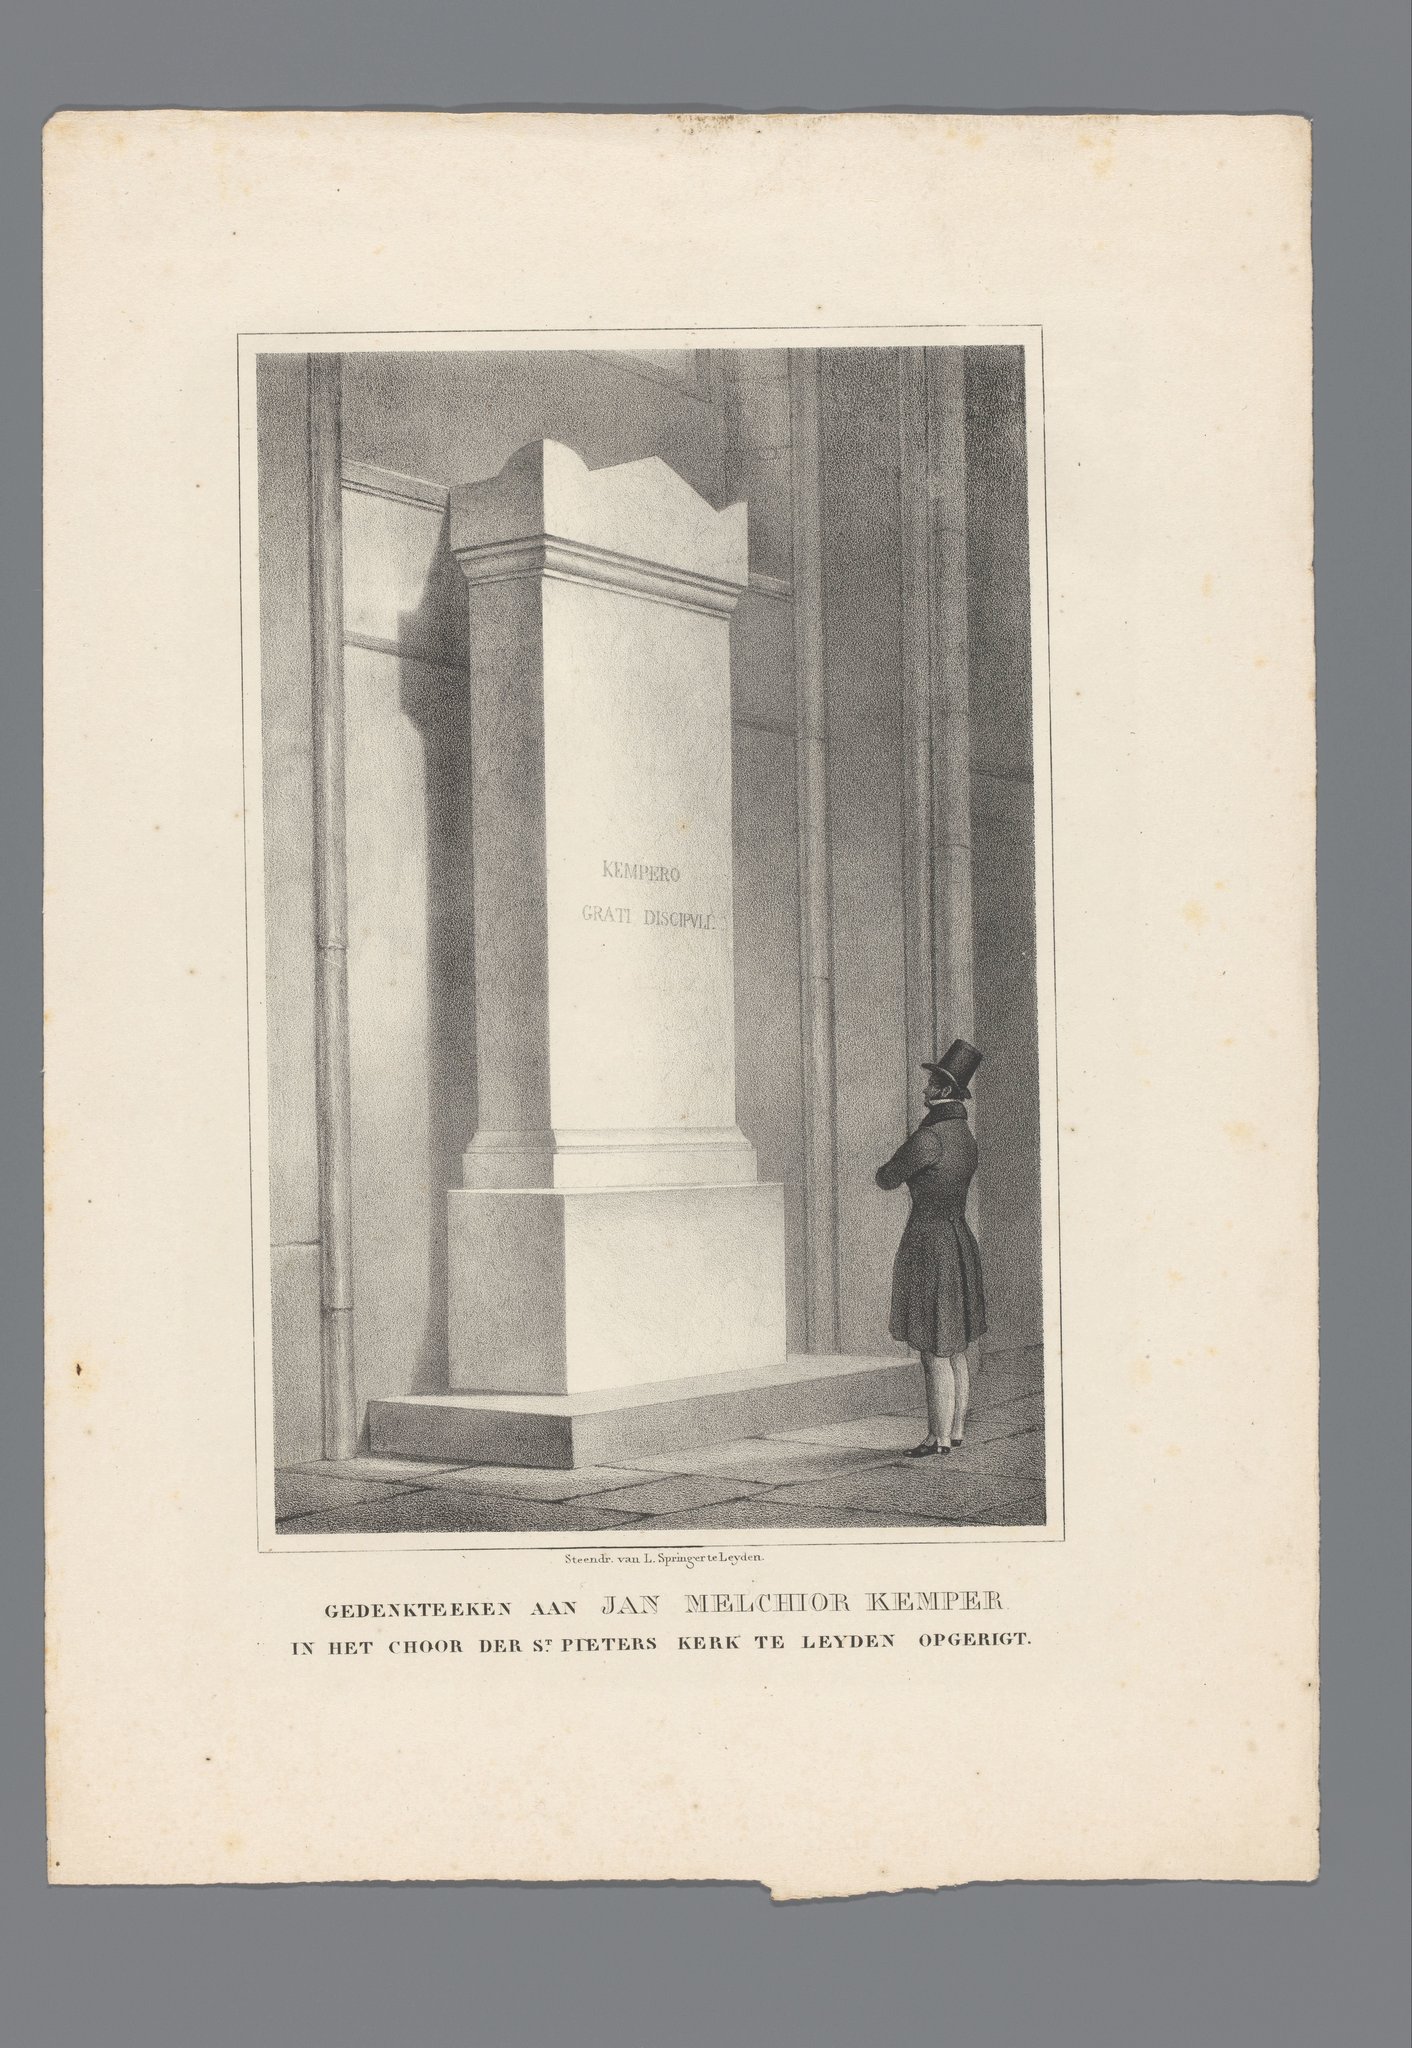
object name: print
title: Gedenkteeken aan Jan Melchior Kemper in het choor der St. Pieters Kerk te Leyden opgerigt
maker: leendert springer (i)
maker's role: draughtsman, painter, print maker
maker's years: 1789-1871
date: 1835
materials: paper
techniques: lithograph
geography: leiden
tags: leiden, jonkheer joan melchior kemper, grave-building, monumental tomb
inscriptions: collector's mark: Lugt 2228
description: Gedenkteken voor de Leidse professor Jan Melchior Kemper (overleden 20 juli 1824) opgericht in de Pieterskerk te Leiden op 30 mei 1835. Een man staande voor het sobere monument ontworpen door D. Humbert de Superville.